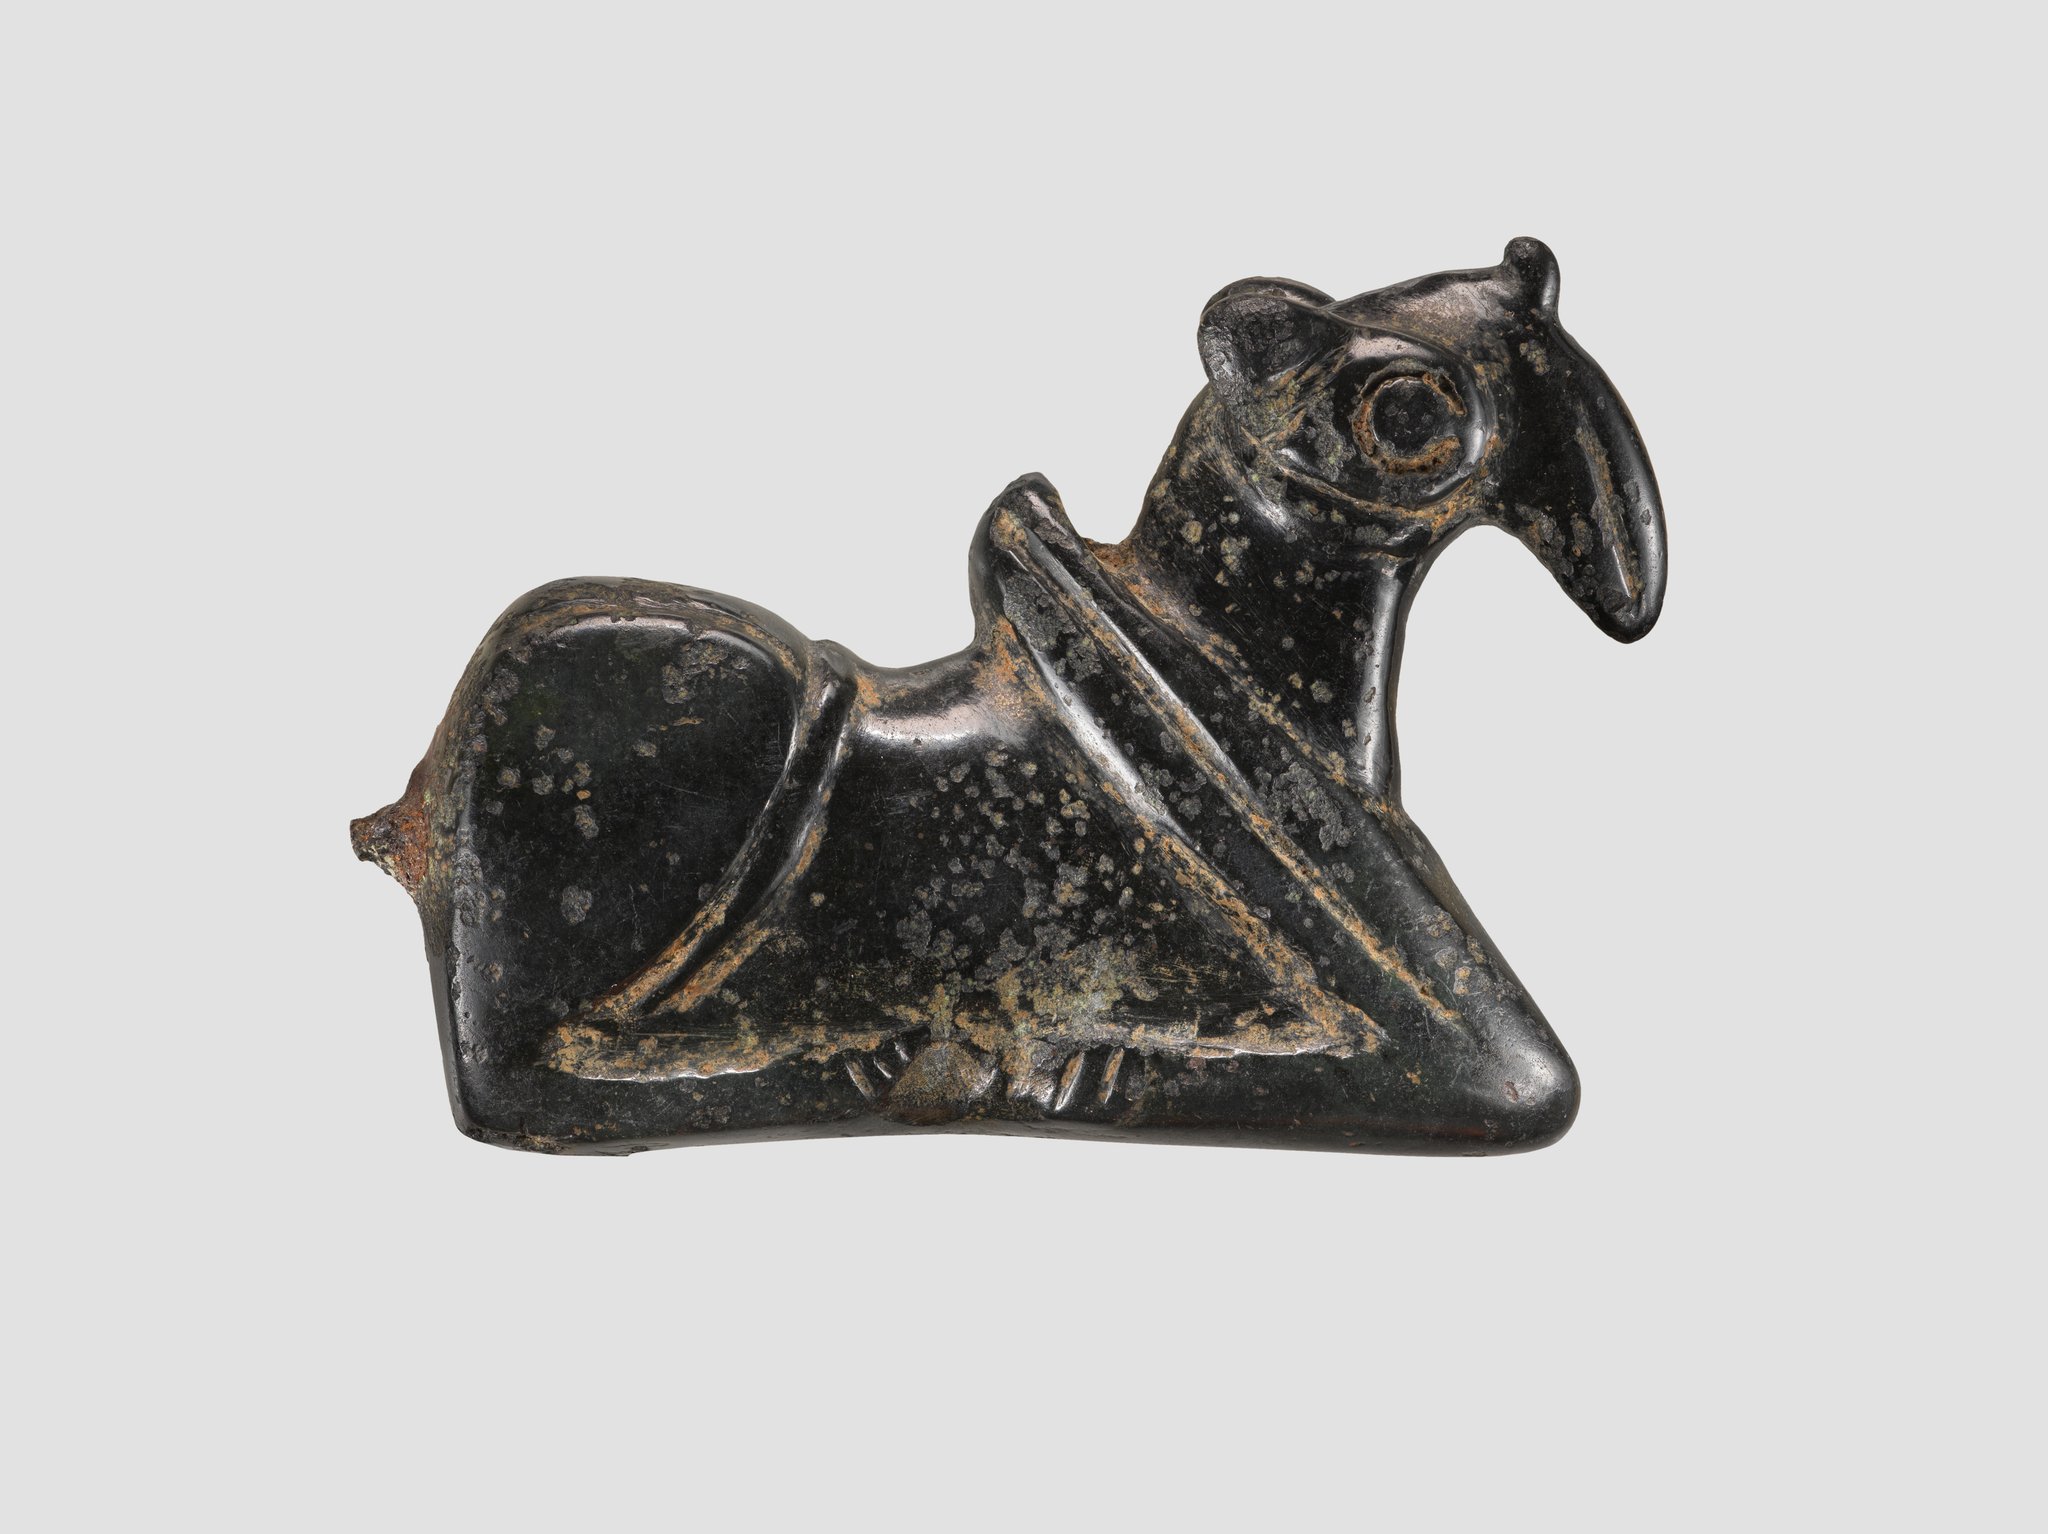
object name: pin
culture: iranian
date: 800-601 BCE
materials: bronze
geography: iran, probably from luristan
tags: animals